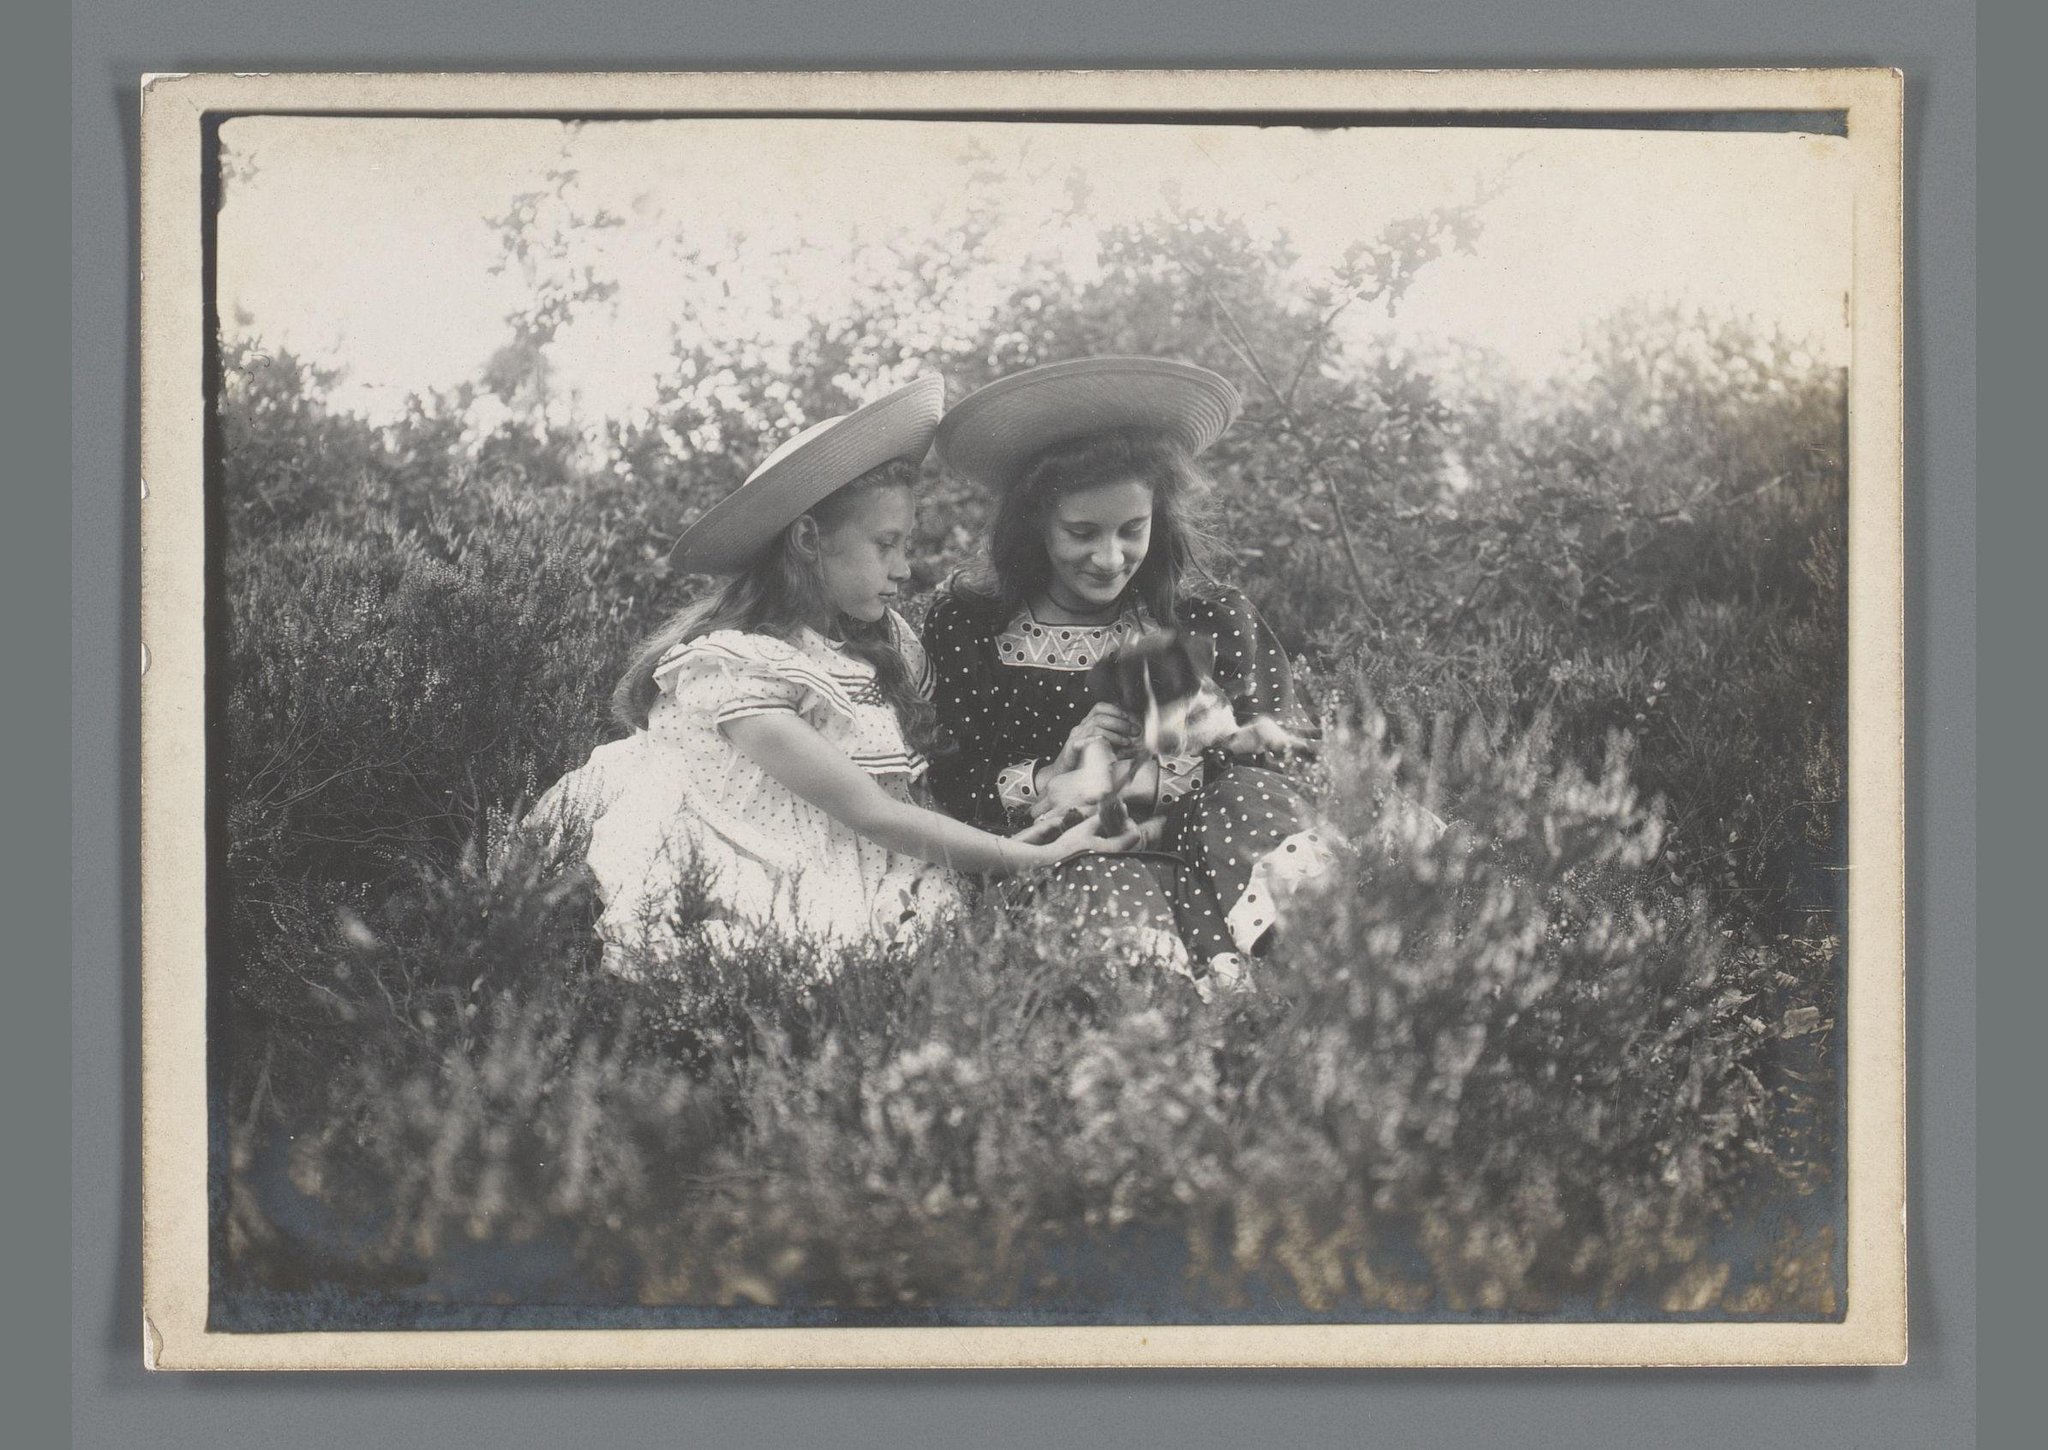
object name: photograph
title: Johanna (Hans) de Jong en Johanna (Nan) Vreede met hond op schoot in heidelandschap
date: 1900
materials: paper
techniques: gelatin silver print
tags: leiden, johanna petronella lambertina stokhuyzen-de jong (hans), surabaya, johanna elisabeth borgerhoff mulder-vreede (nan), historical persons, dog, netherlands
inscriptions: inscription: ‘H. + Nan.’